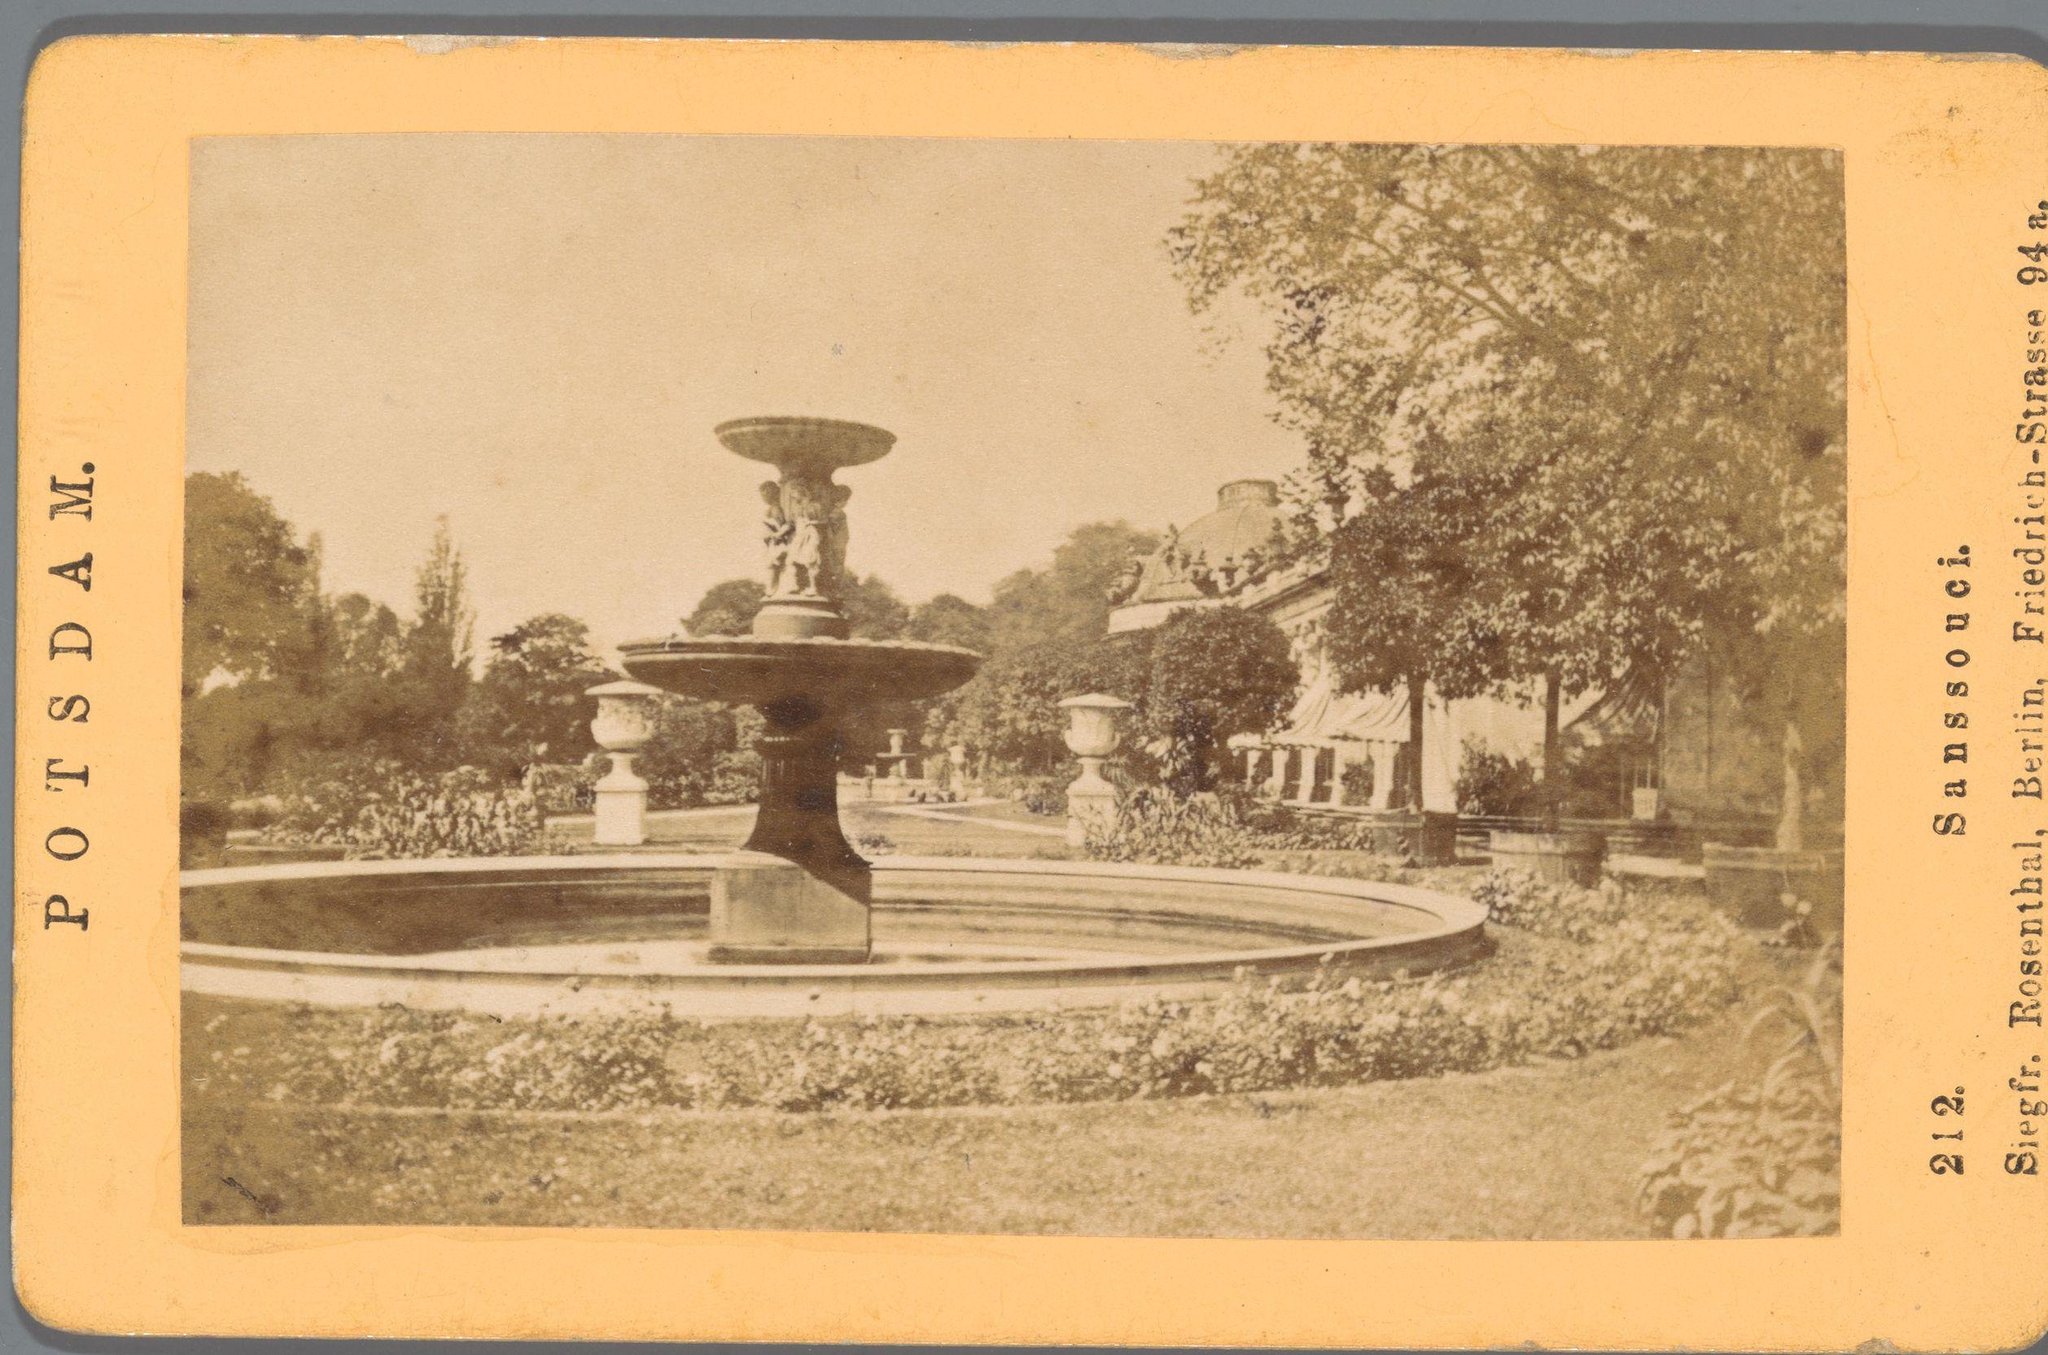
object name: carte de visite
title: Sanssouci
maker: siegfried rosenthal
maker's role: fotograaf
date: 1855-1885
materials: cardboard, paper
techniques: albumen print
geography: sanssouci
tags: garden fountain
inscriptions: number: ‘212.’, address: ‘Berlin, Friedrich-Strasse 94a.’